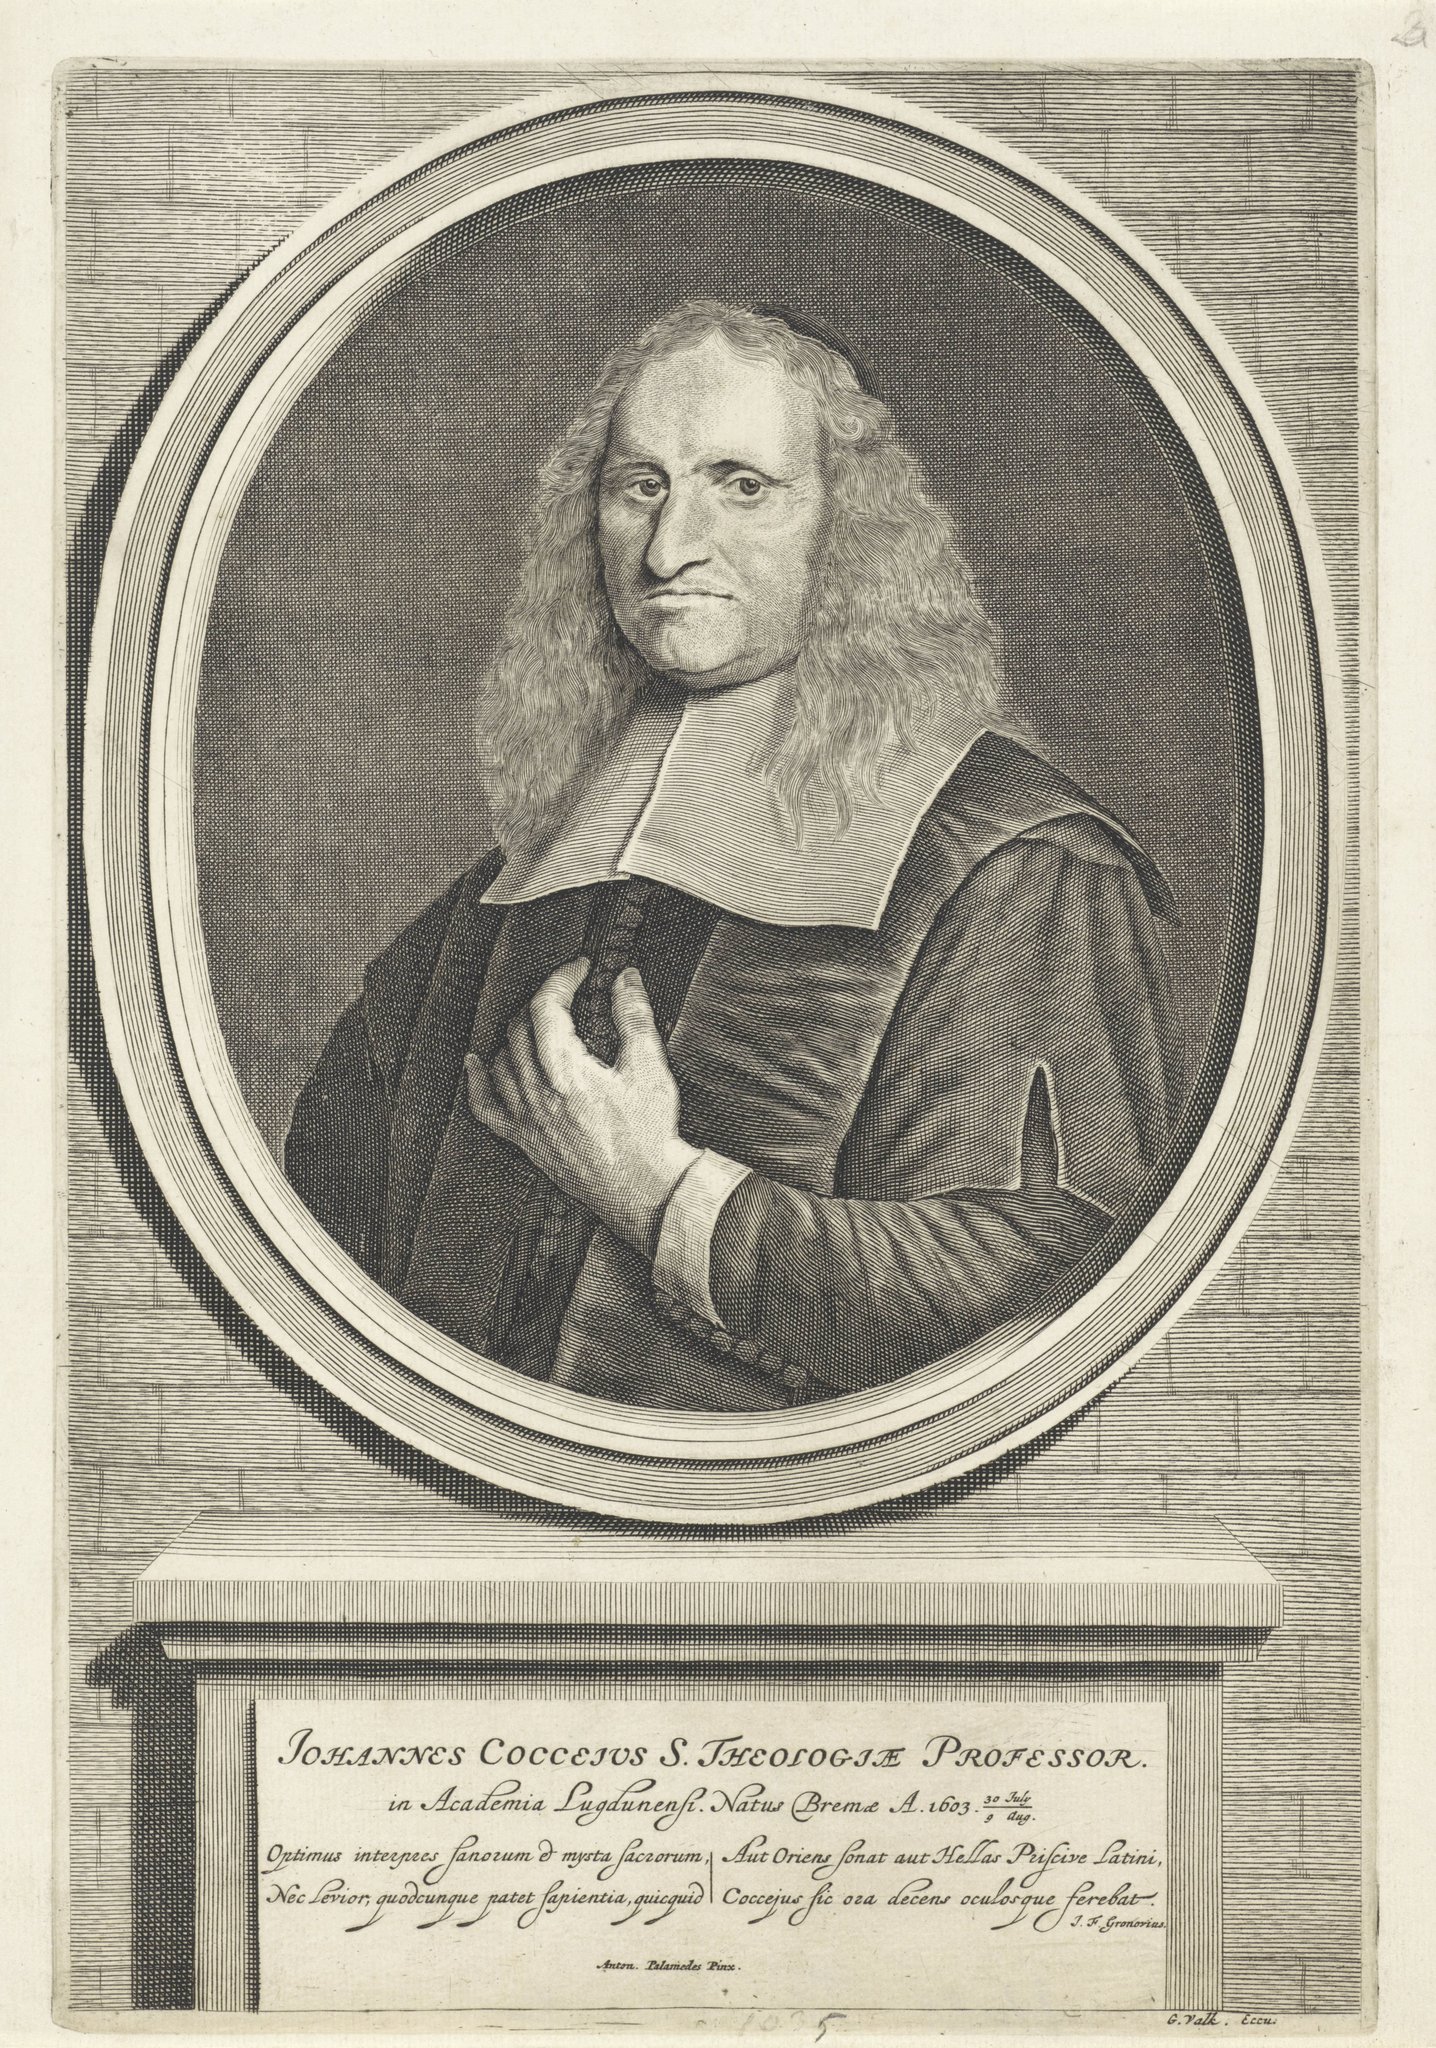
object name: print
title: Portret van Johannes Cocceius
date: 1670-1726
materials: paper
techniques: engraving, etching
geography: amsterdam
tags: historical persons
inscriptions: collector's mark: Lugt 2228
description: Portret van de theoloog Johannes Cocceius in een ovale omlijsting. Onder het portret enkele biografische gegevens en de functie van de geportretteerde. Daaronder een onderschrift in het Latijn.